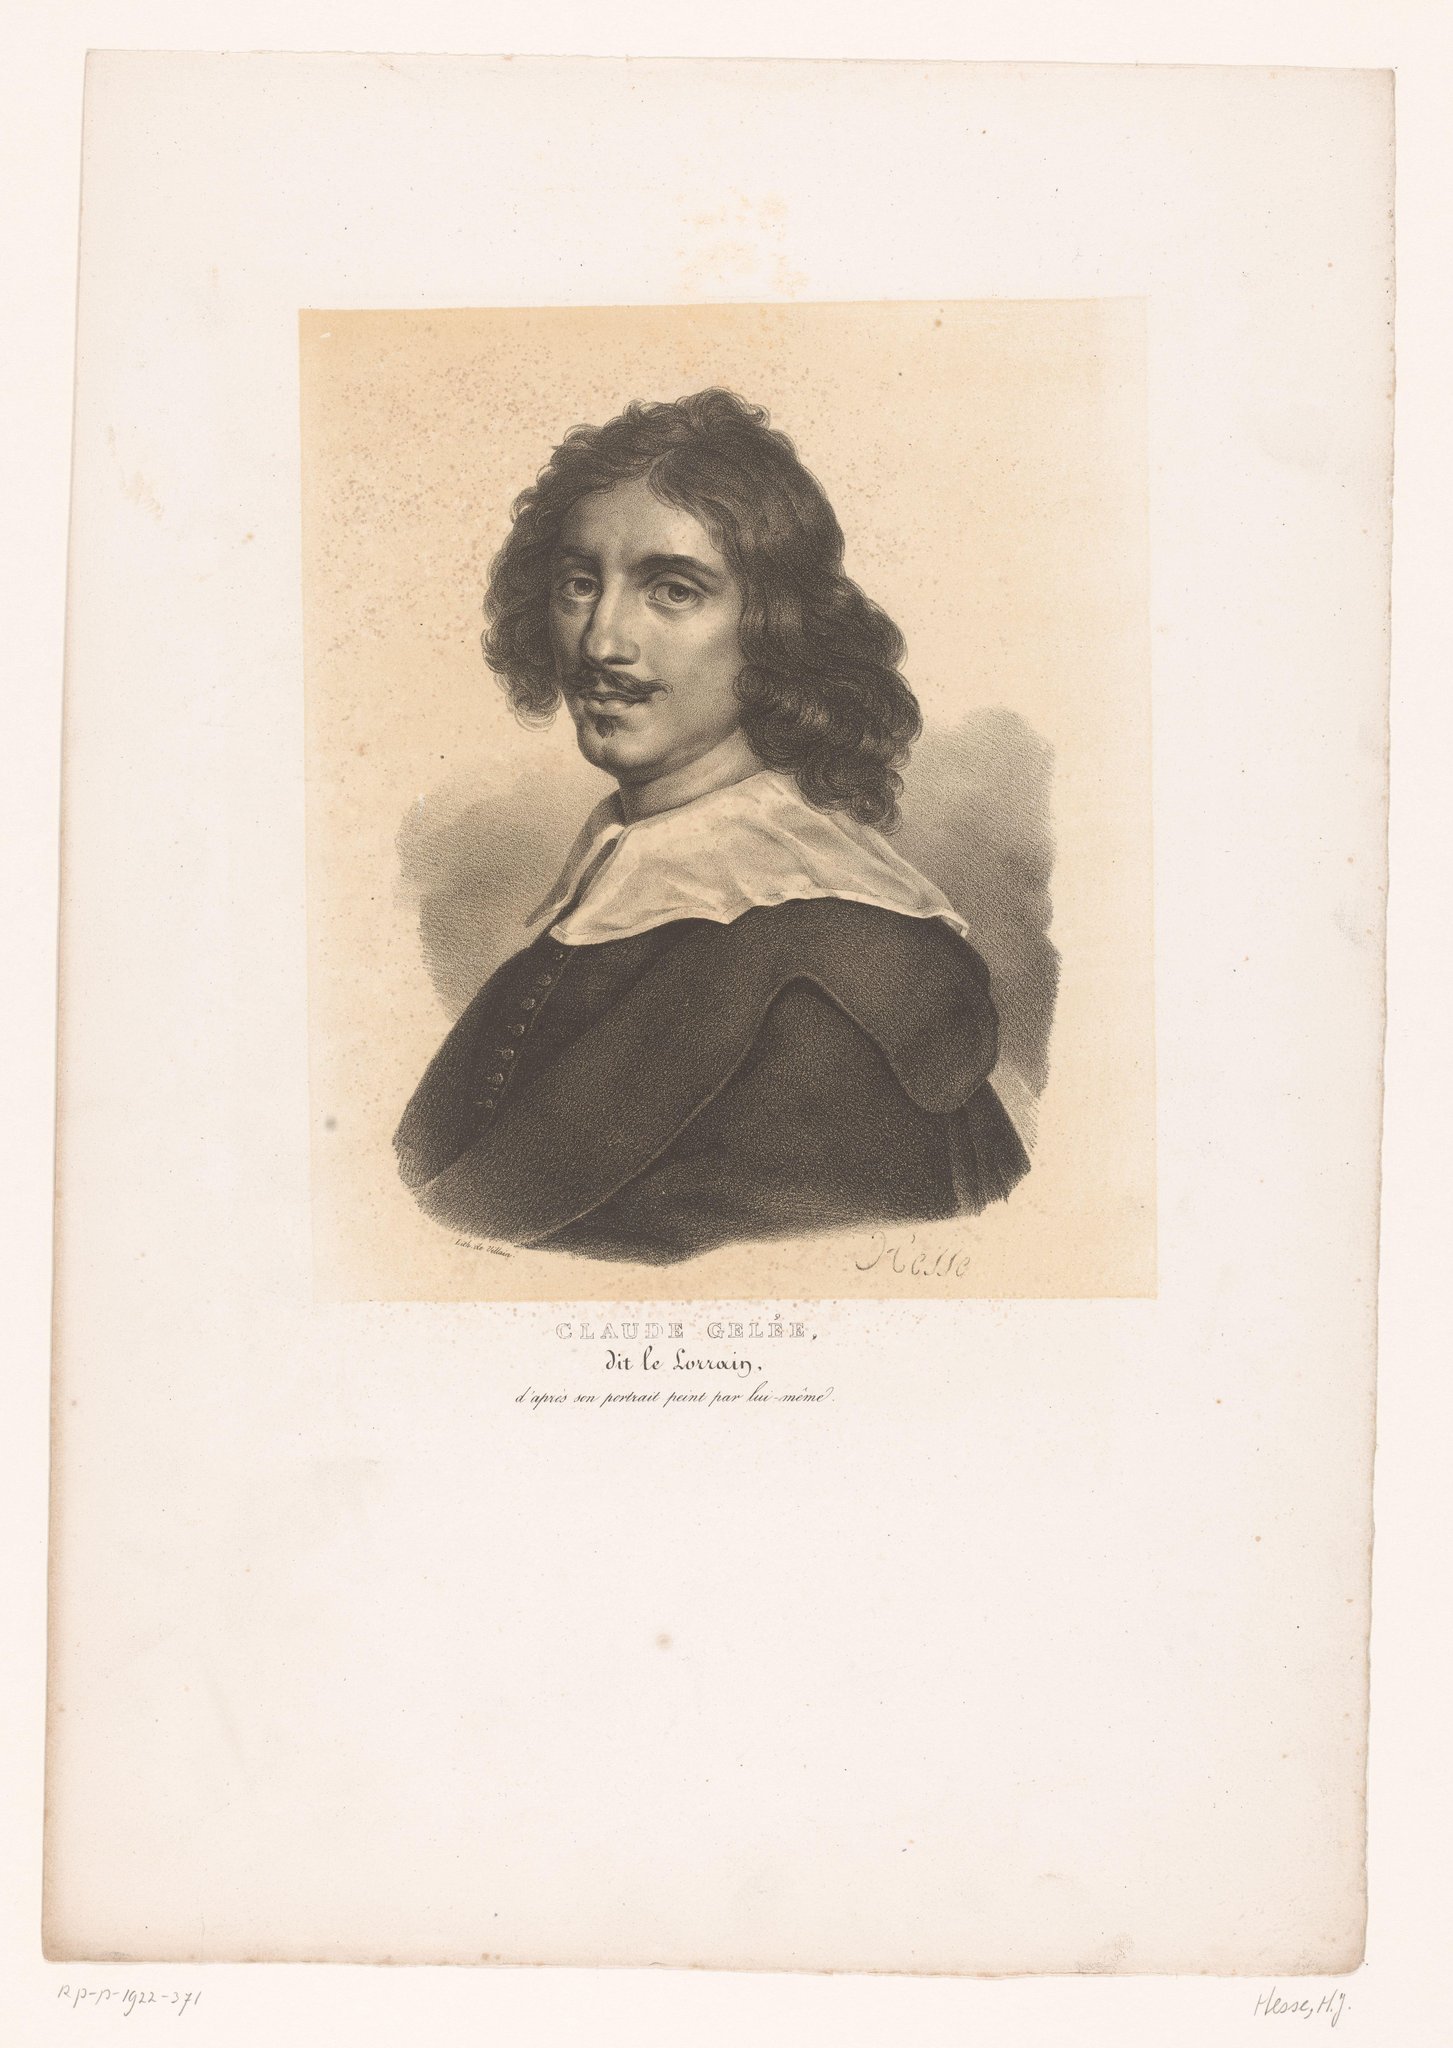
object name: print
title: Claude Gelée, dit le Lorrain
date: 1823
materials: paper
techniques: lithograph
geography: paris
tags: claude lorrain, historical persons, portrait, self-portrait of painter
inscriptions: check stamp: ‘JC (?)’, collector's mark: Lugt 2233